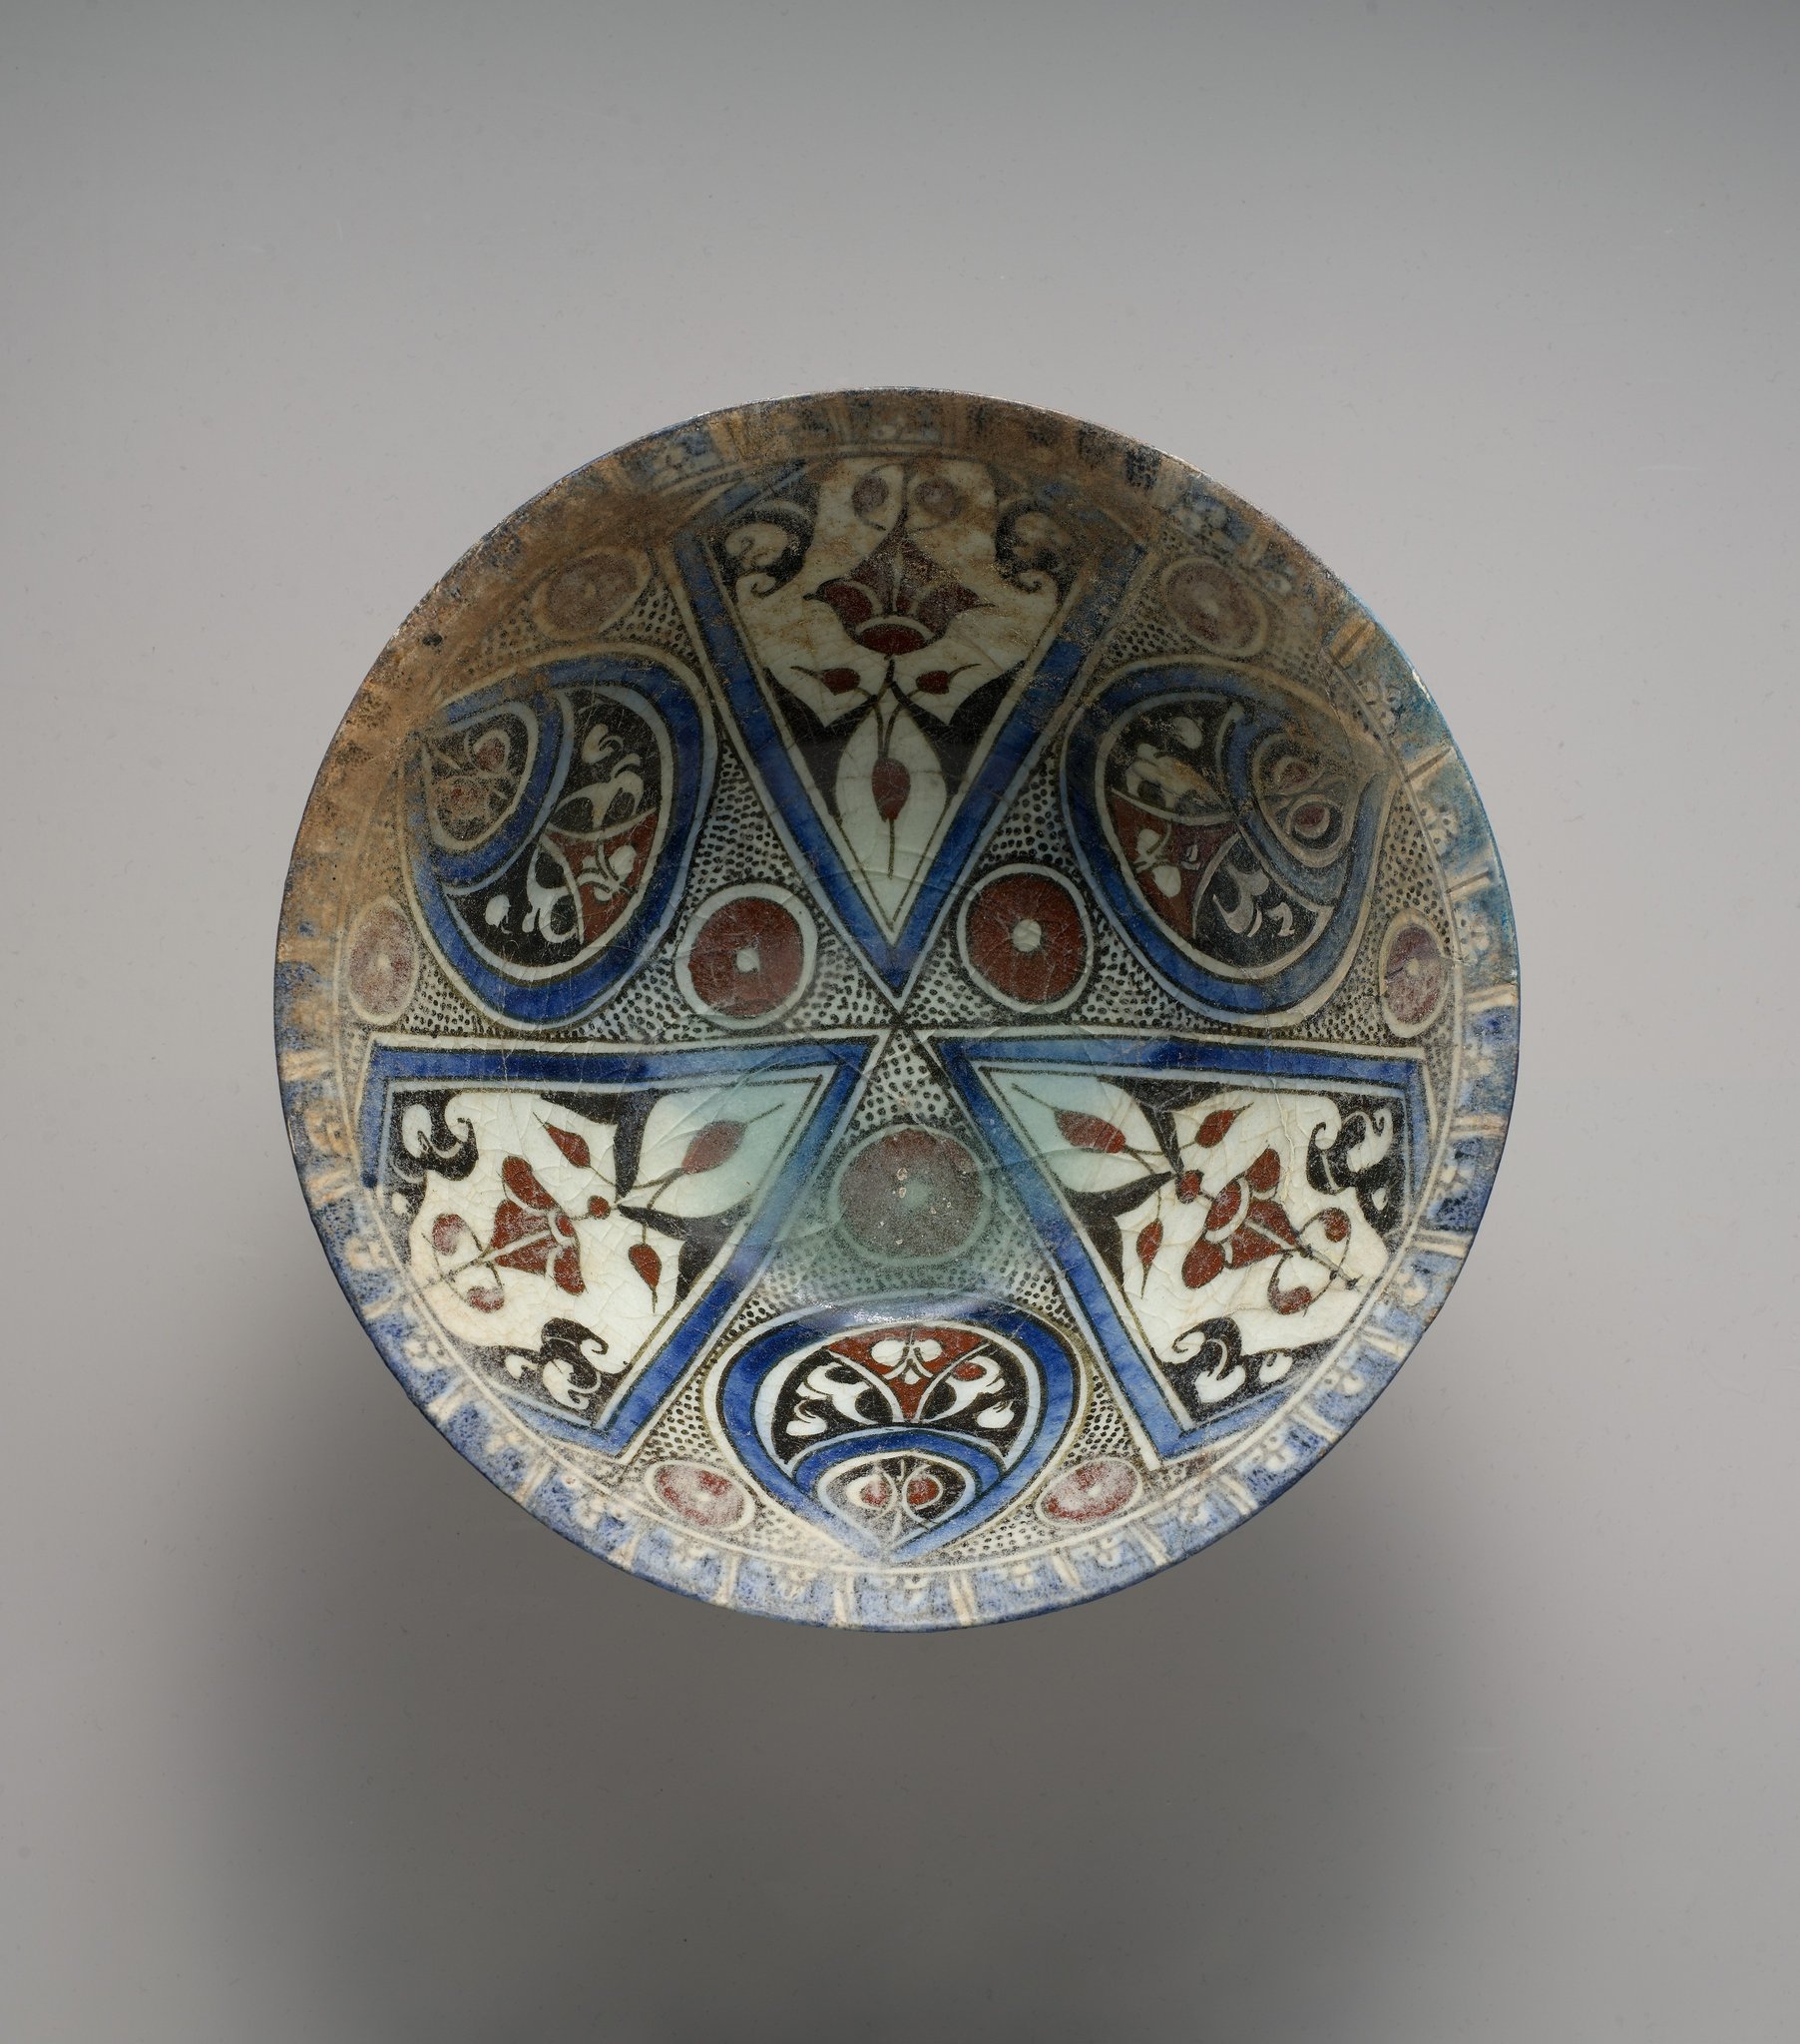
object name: bowl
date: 1167-1233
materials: glaze, stonepaste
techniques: painting, polychrome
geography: syria